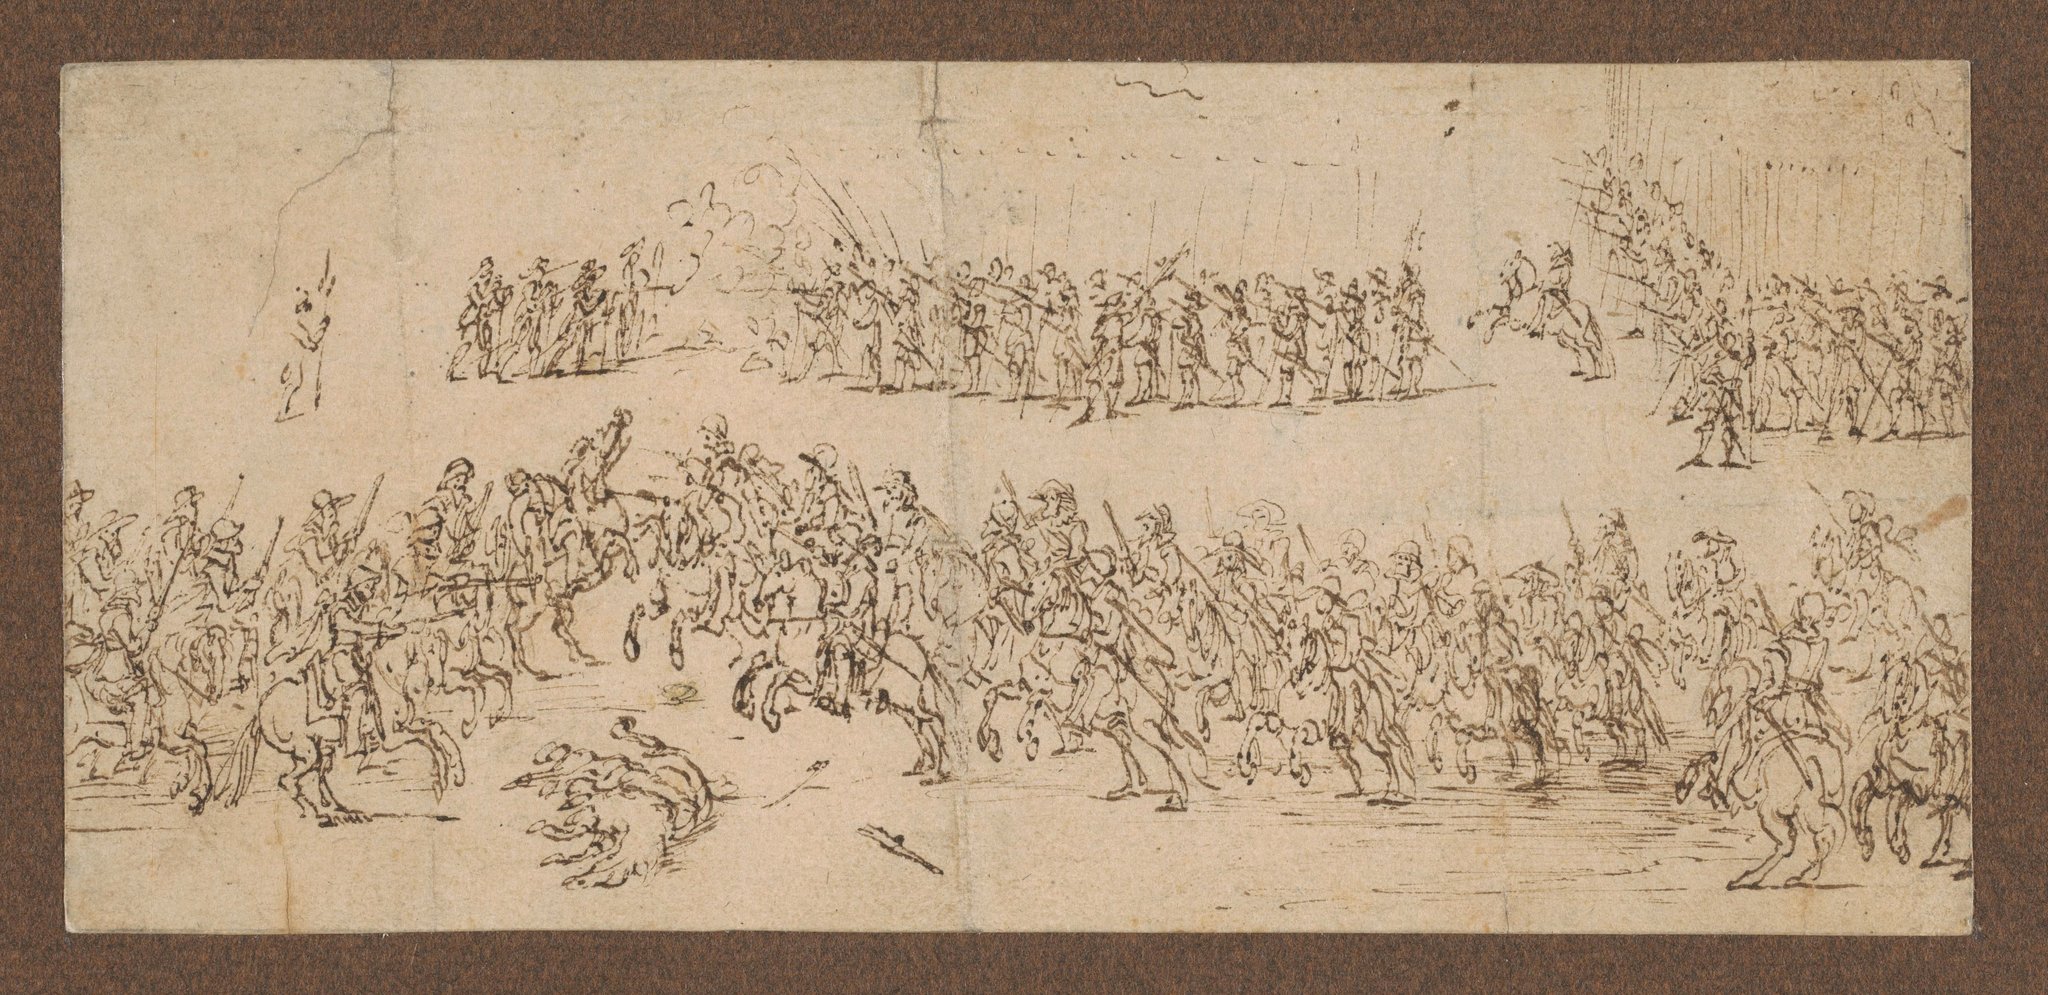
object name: drawing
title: Charges van voetvolk en ruiterij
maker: jacques callot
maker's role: draughtsman, print maker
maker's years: 1592-1635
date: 1602-1635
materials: ink, paper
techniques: pen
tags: battle (+ land forces)